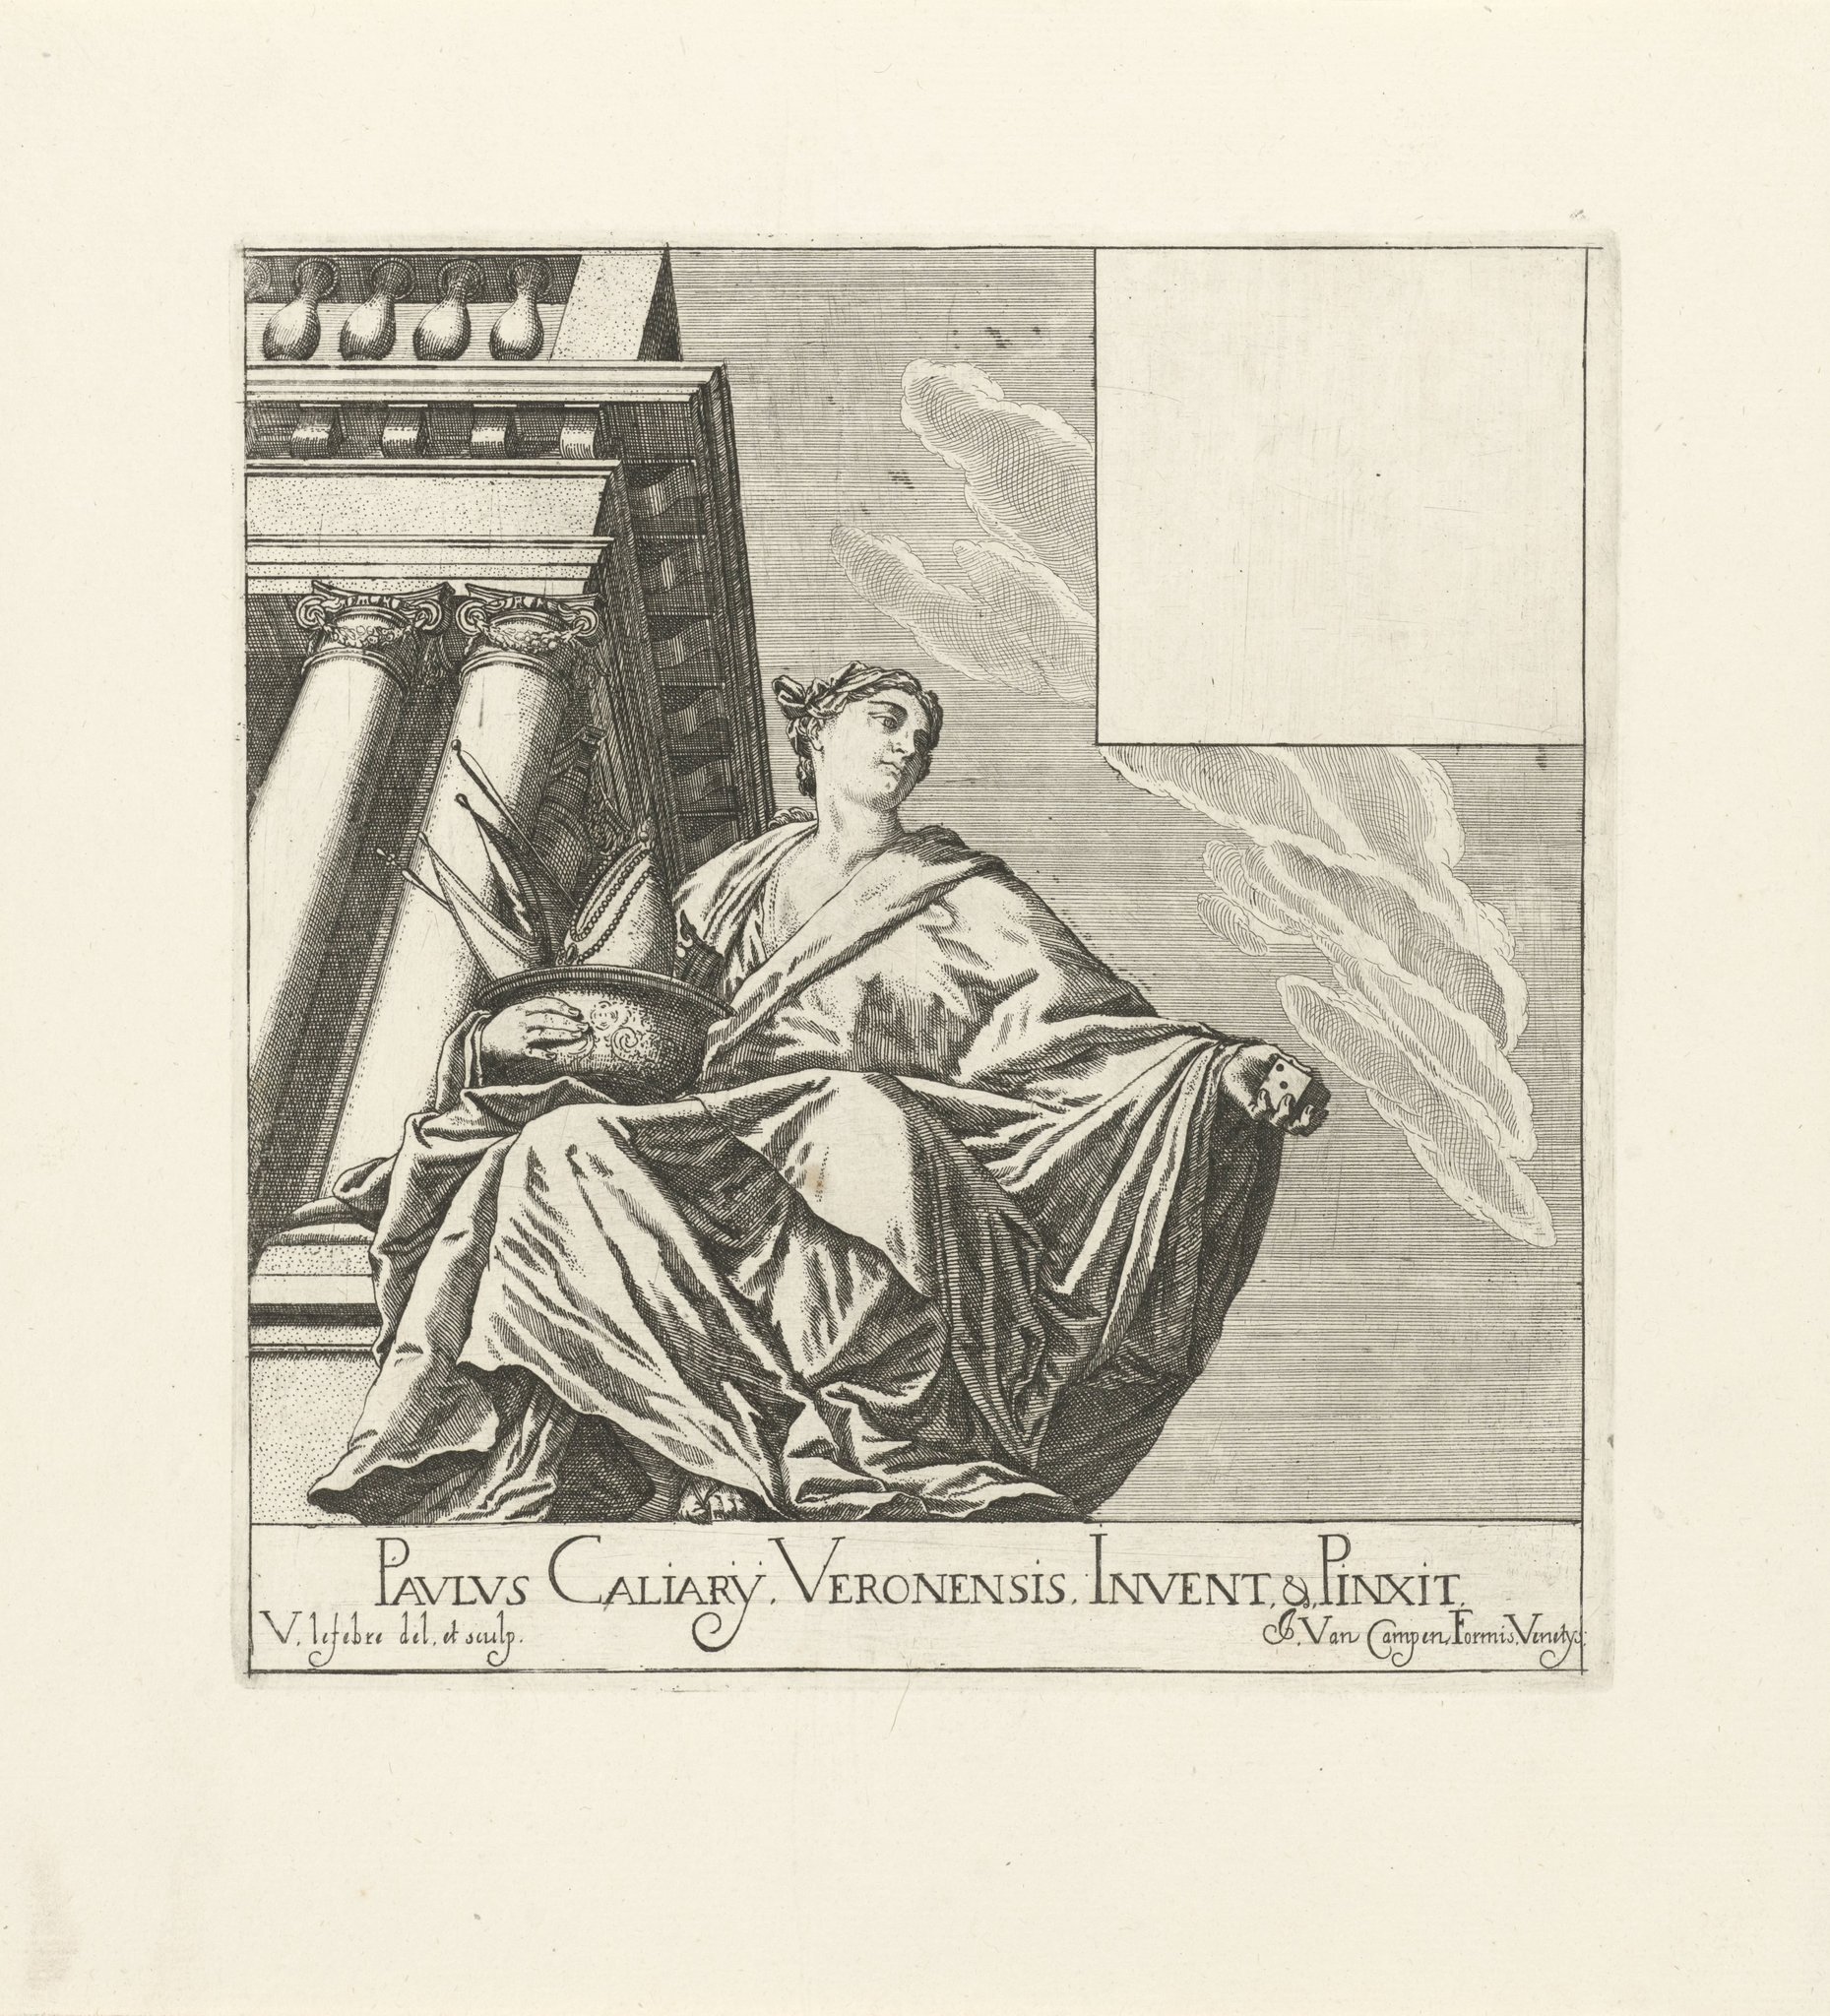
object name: print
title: Opera Selectiora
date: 1682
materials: paper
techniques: etching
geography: venice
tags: luck, fortune, lot; 'fato', 'fortuna', 'fortuna aurea', 'fortuna buona', 'fortuna pacifica overo clemente', 'sorte' (ripa), dice, insignia and symbols of sovereignty (crown, diadem, sceptre, orb, seal, standard, cloak, pectoral)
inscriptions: collector's mark: Lugt 2228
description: Fortuin (Fortuna), de personificatie van het lot, zit met een dobbelsteen en een bokaal gevuld met mijters, scepters en kronen voor een tempel. De prent maakt deel uit van een 53-delige serie prenten naar schilderijen van Titiaan en Veronese.